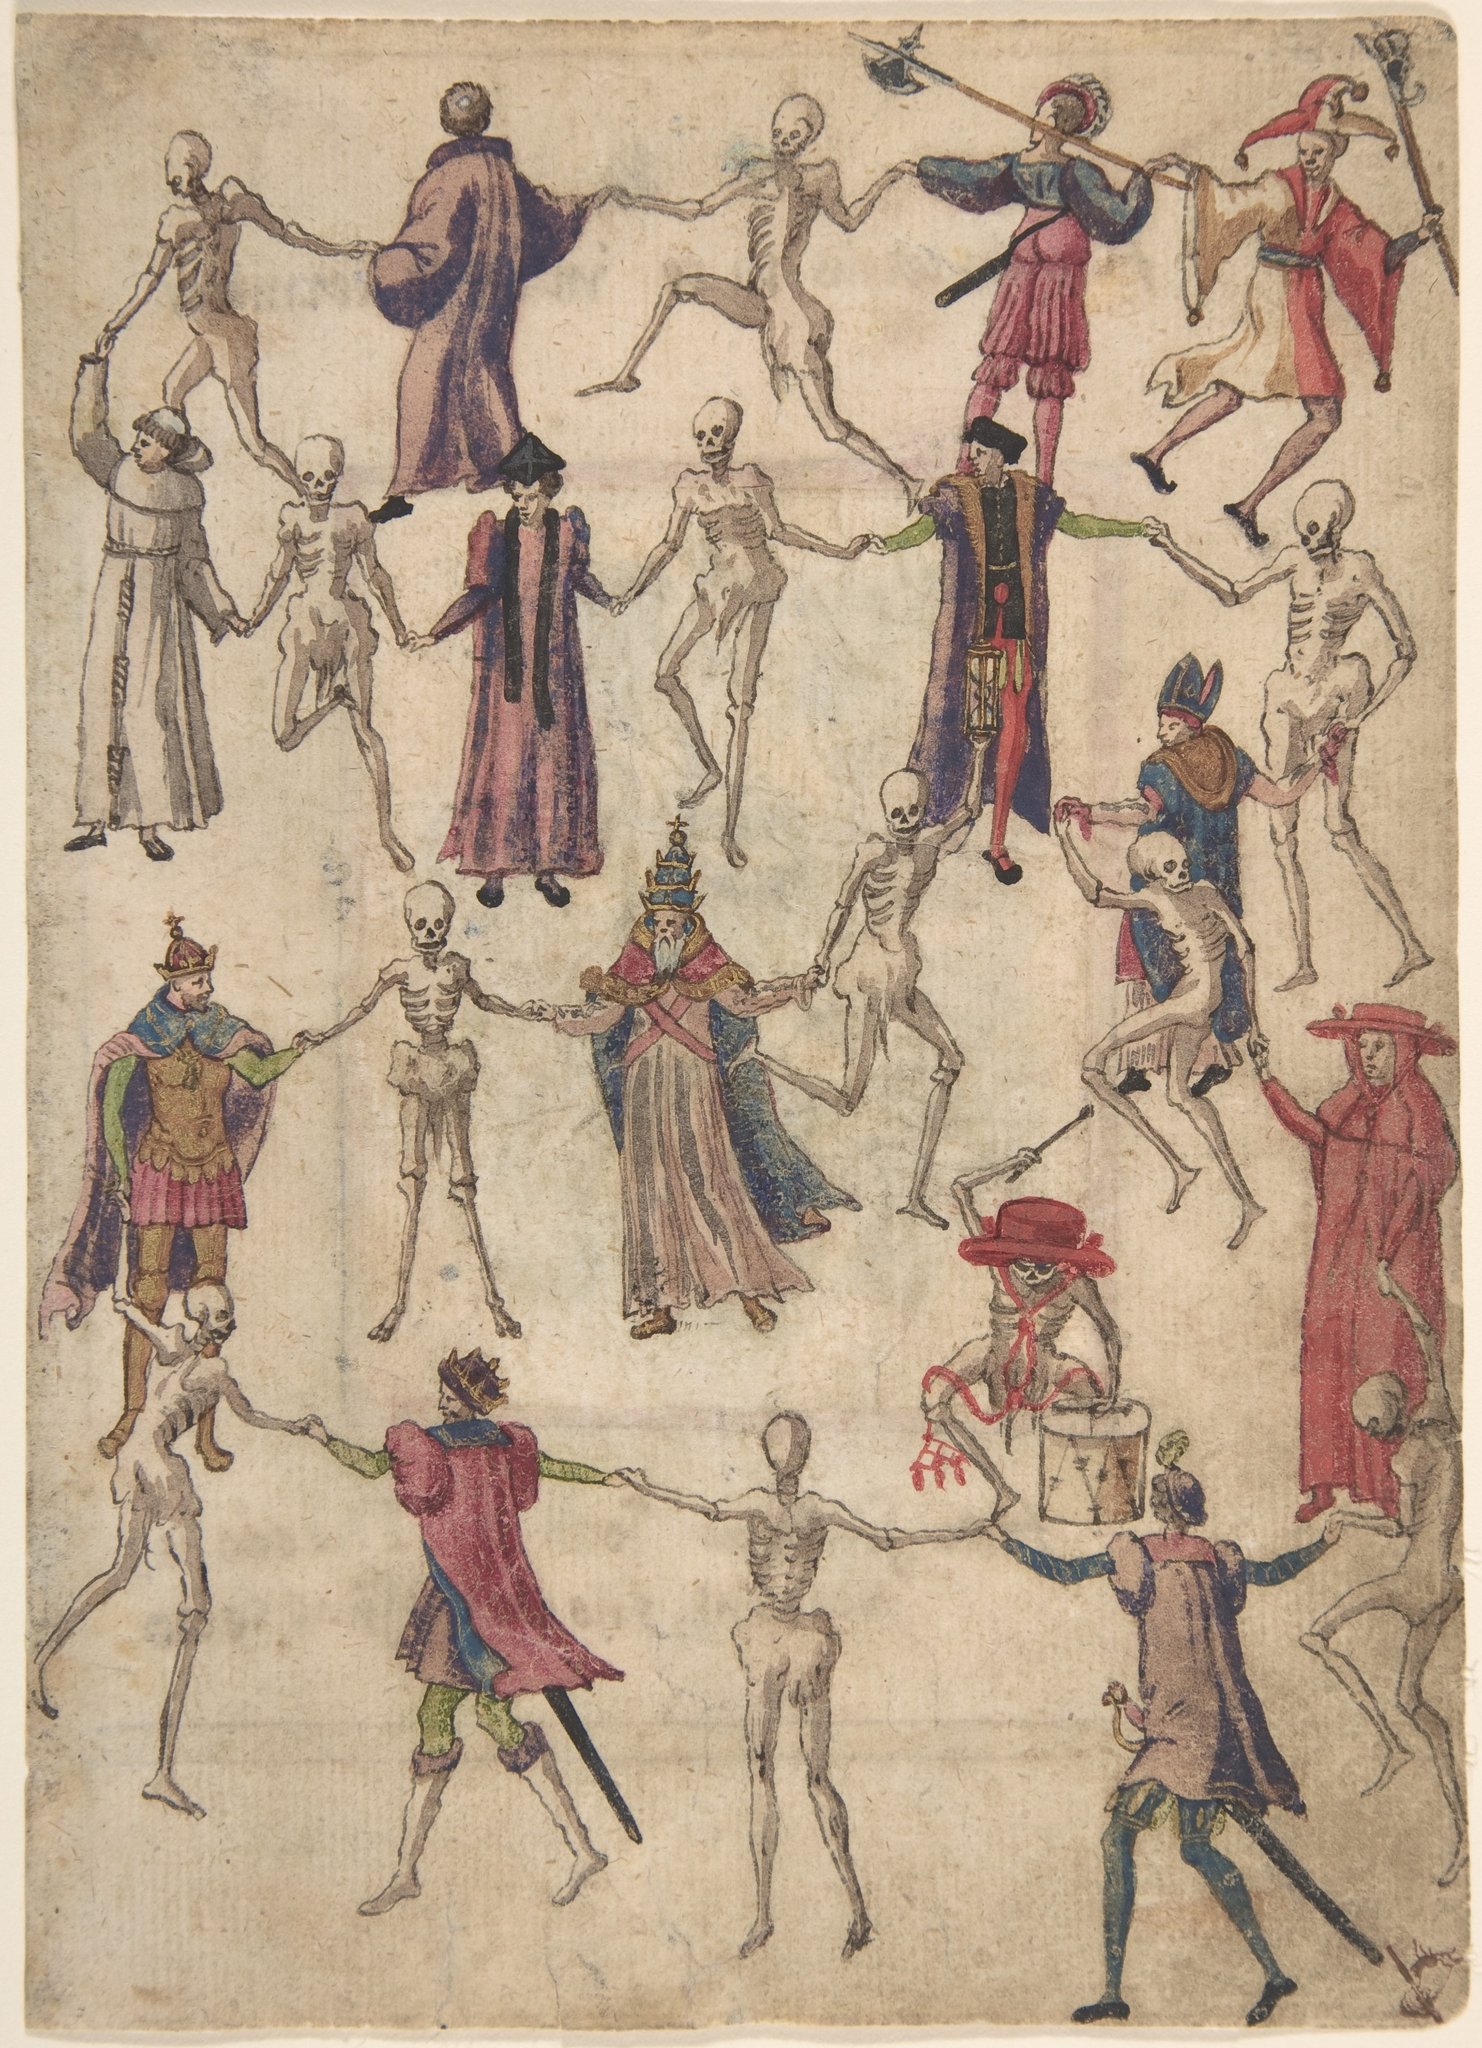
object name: drawing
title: The Dance of Death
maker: anonymous, german, 16th century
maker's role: artist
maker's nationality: german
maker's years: 1500-1600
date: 1501-1600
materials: gold paint, gouache, ink, watercolor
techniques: brush, pen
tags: human figures,dance,skeletons,dancing